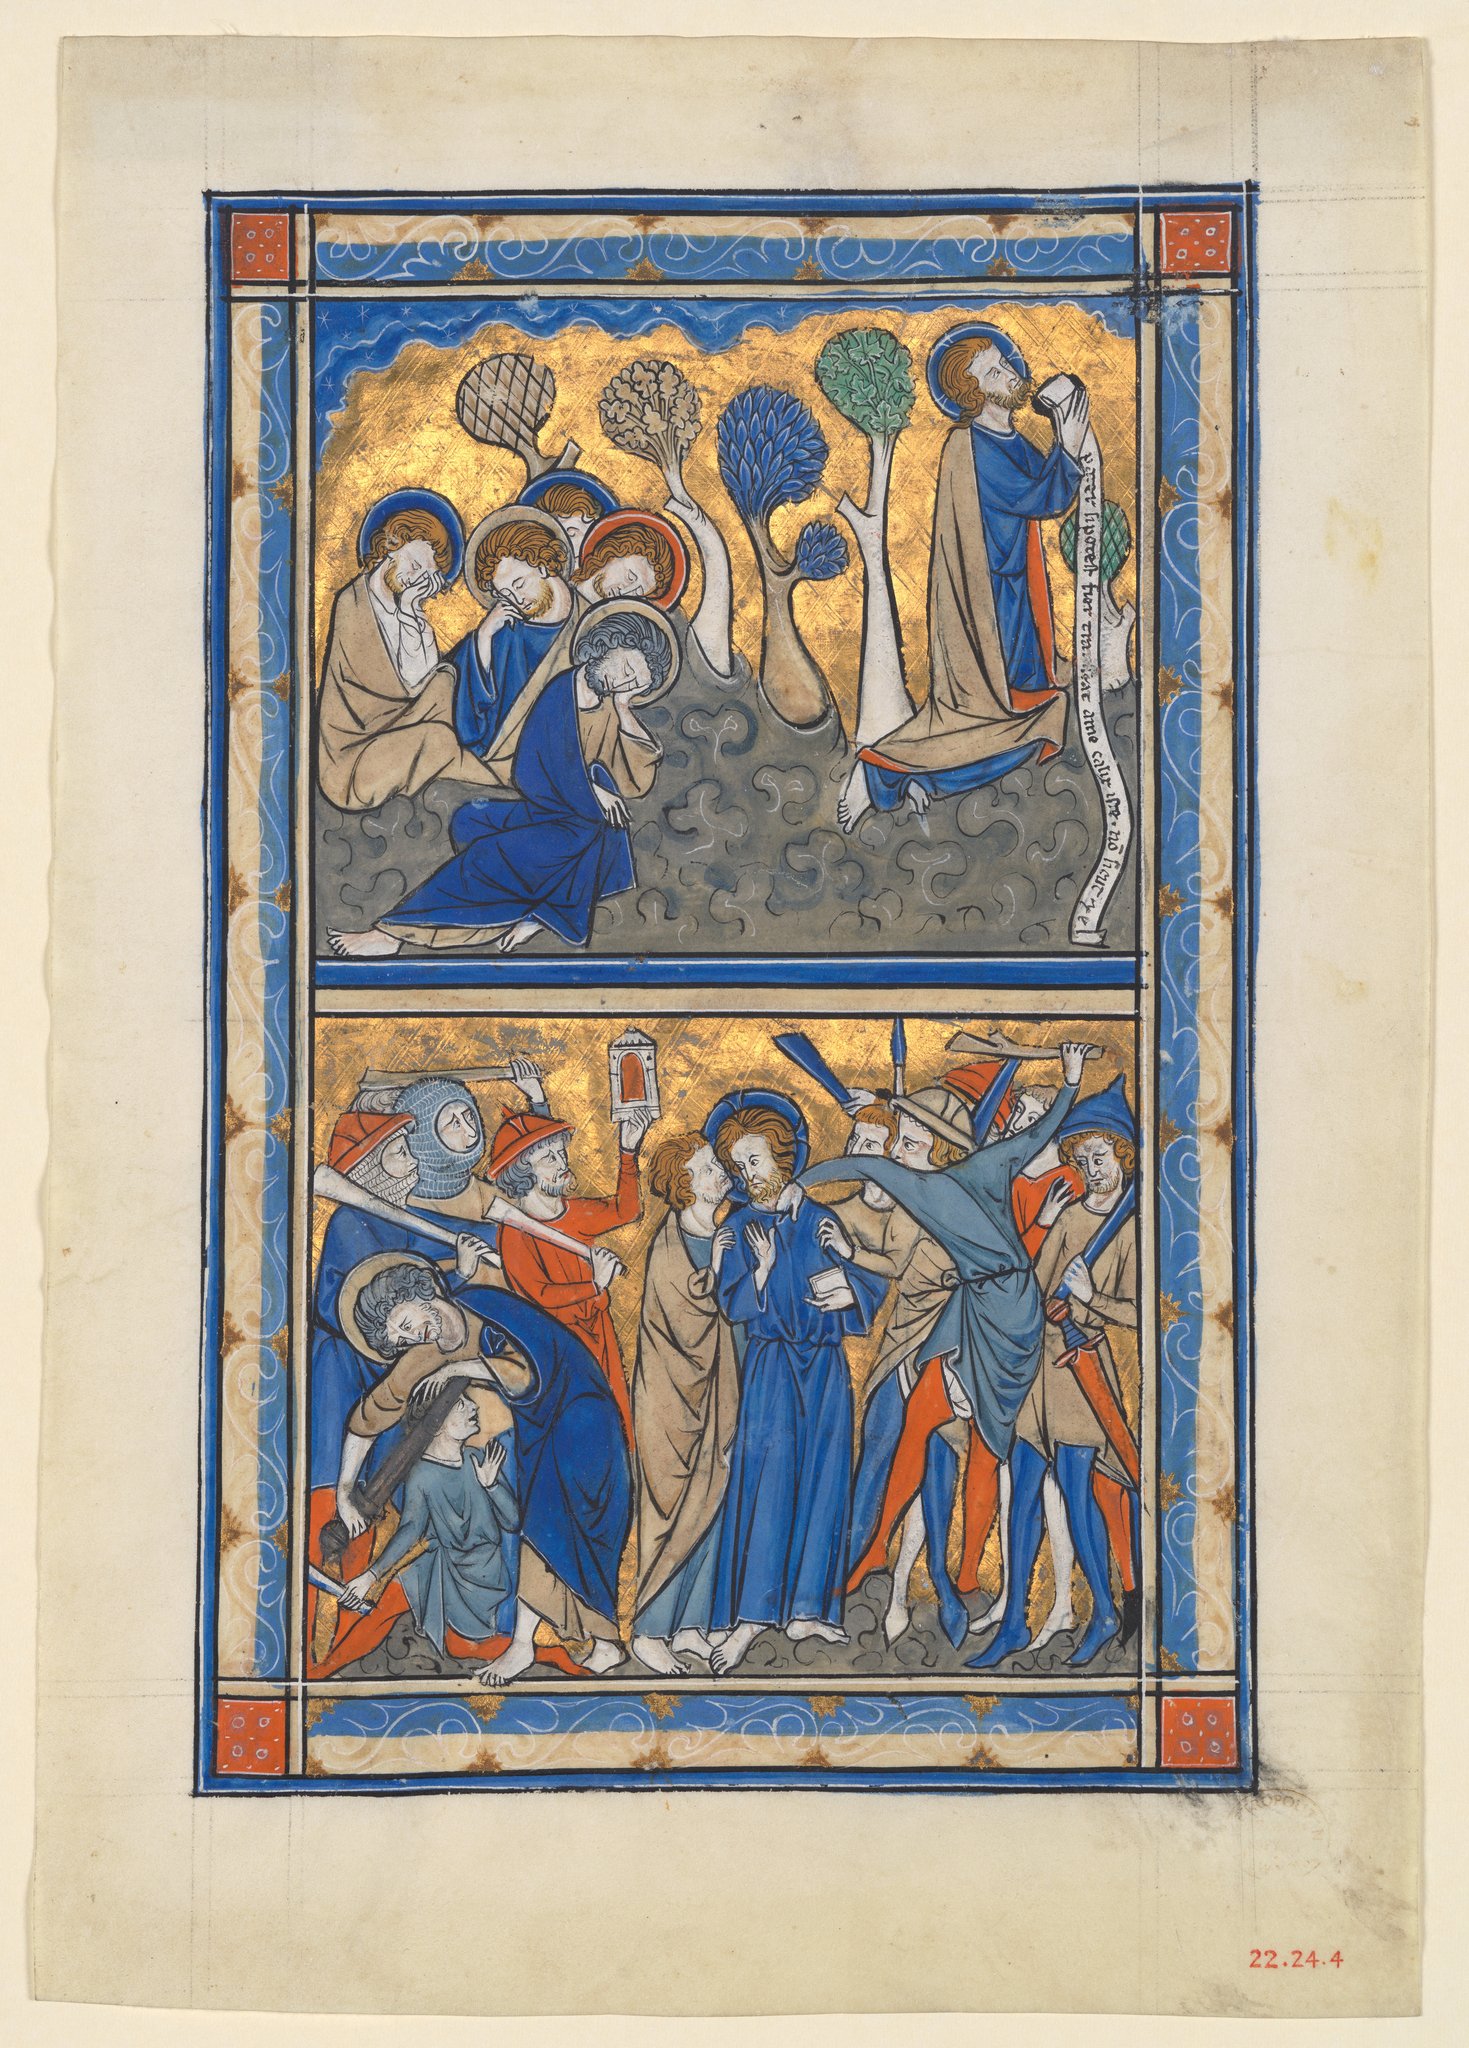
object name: psalter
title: Manuscript Leaf with the Agony in the Garden and Betrayal of Christ, from a Royal Psalter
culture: british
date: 1270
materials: gold, parchment, paint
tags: apostles,christ,judas,agony in the garden